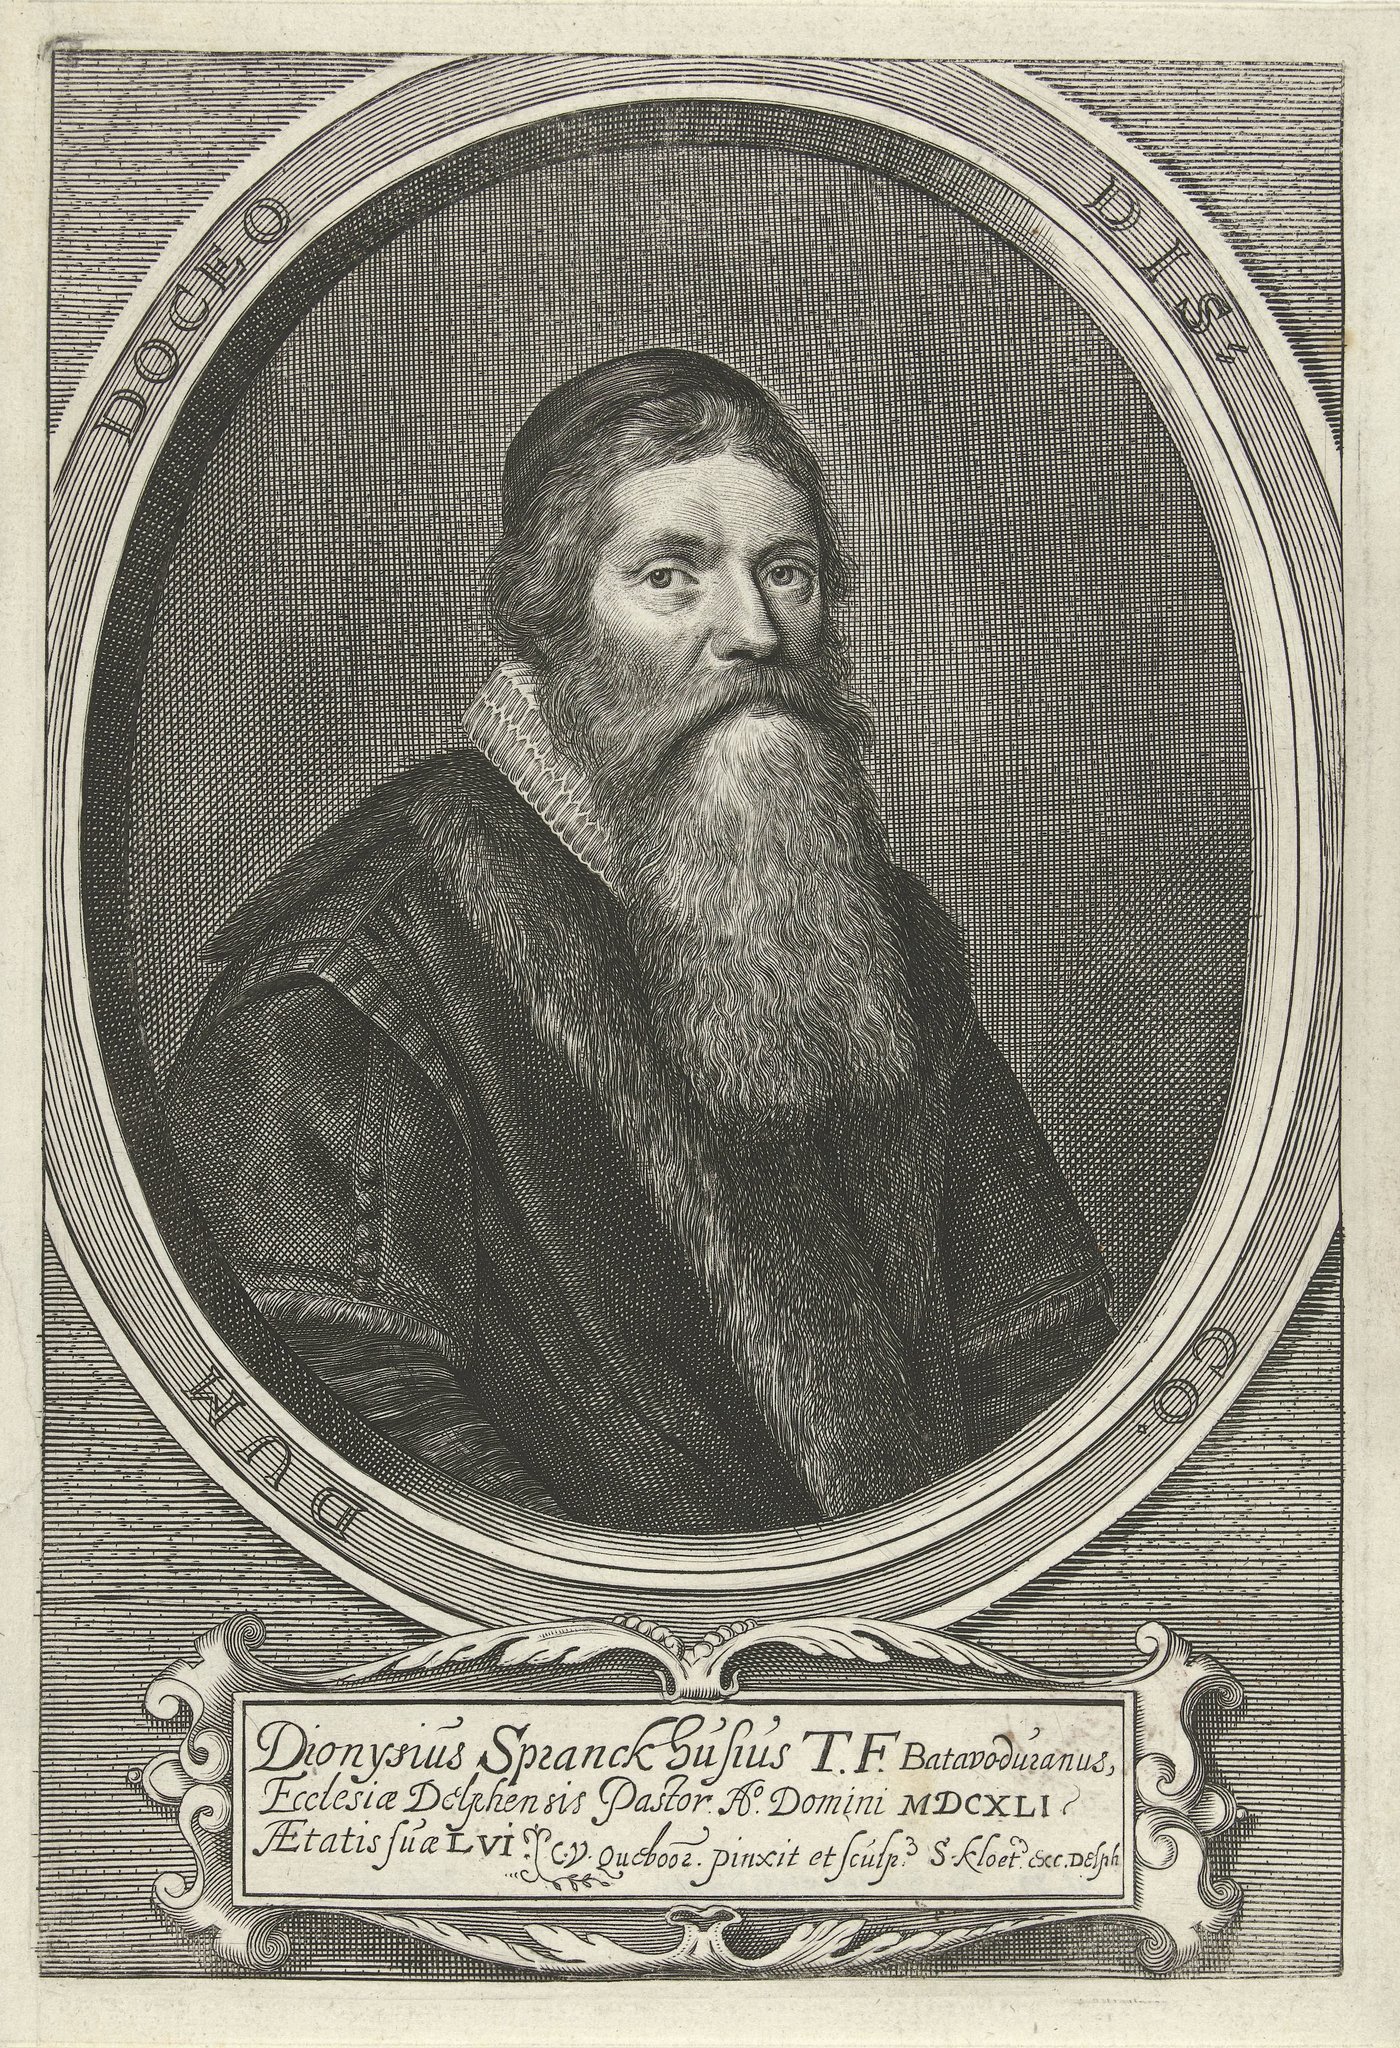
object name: print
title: Portret van Dionysius Spranckhuysen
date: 1641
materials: paper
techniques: engraving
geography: delft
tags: predikant, dionysius spranckhuysen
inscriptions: collector's mark: Lugt 240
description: Portret van de predikant Dionysius Spranckhuysen, op 56 jarige leeftijd. Onder het portret een cartouche met zijn naam en titels in het Latijn.